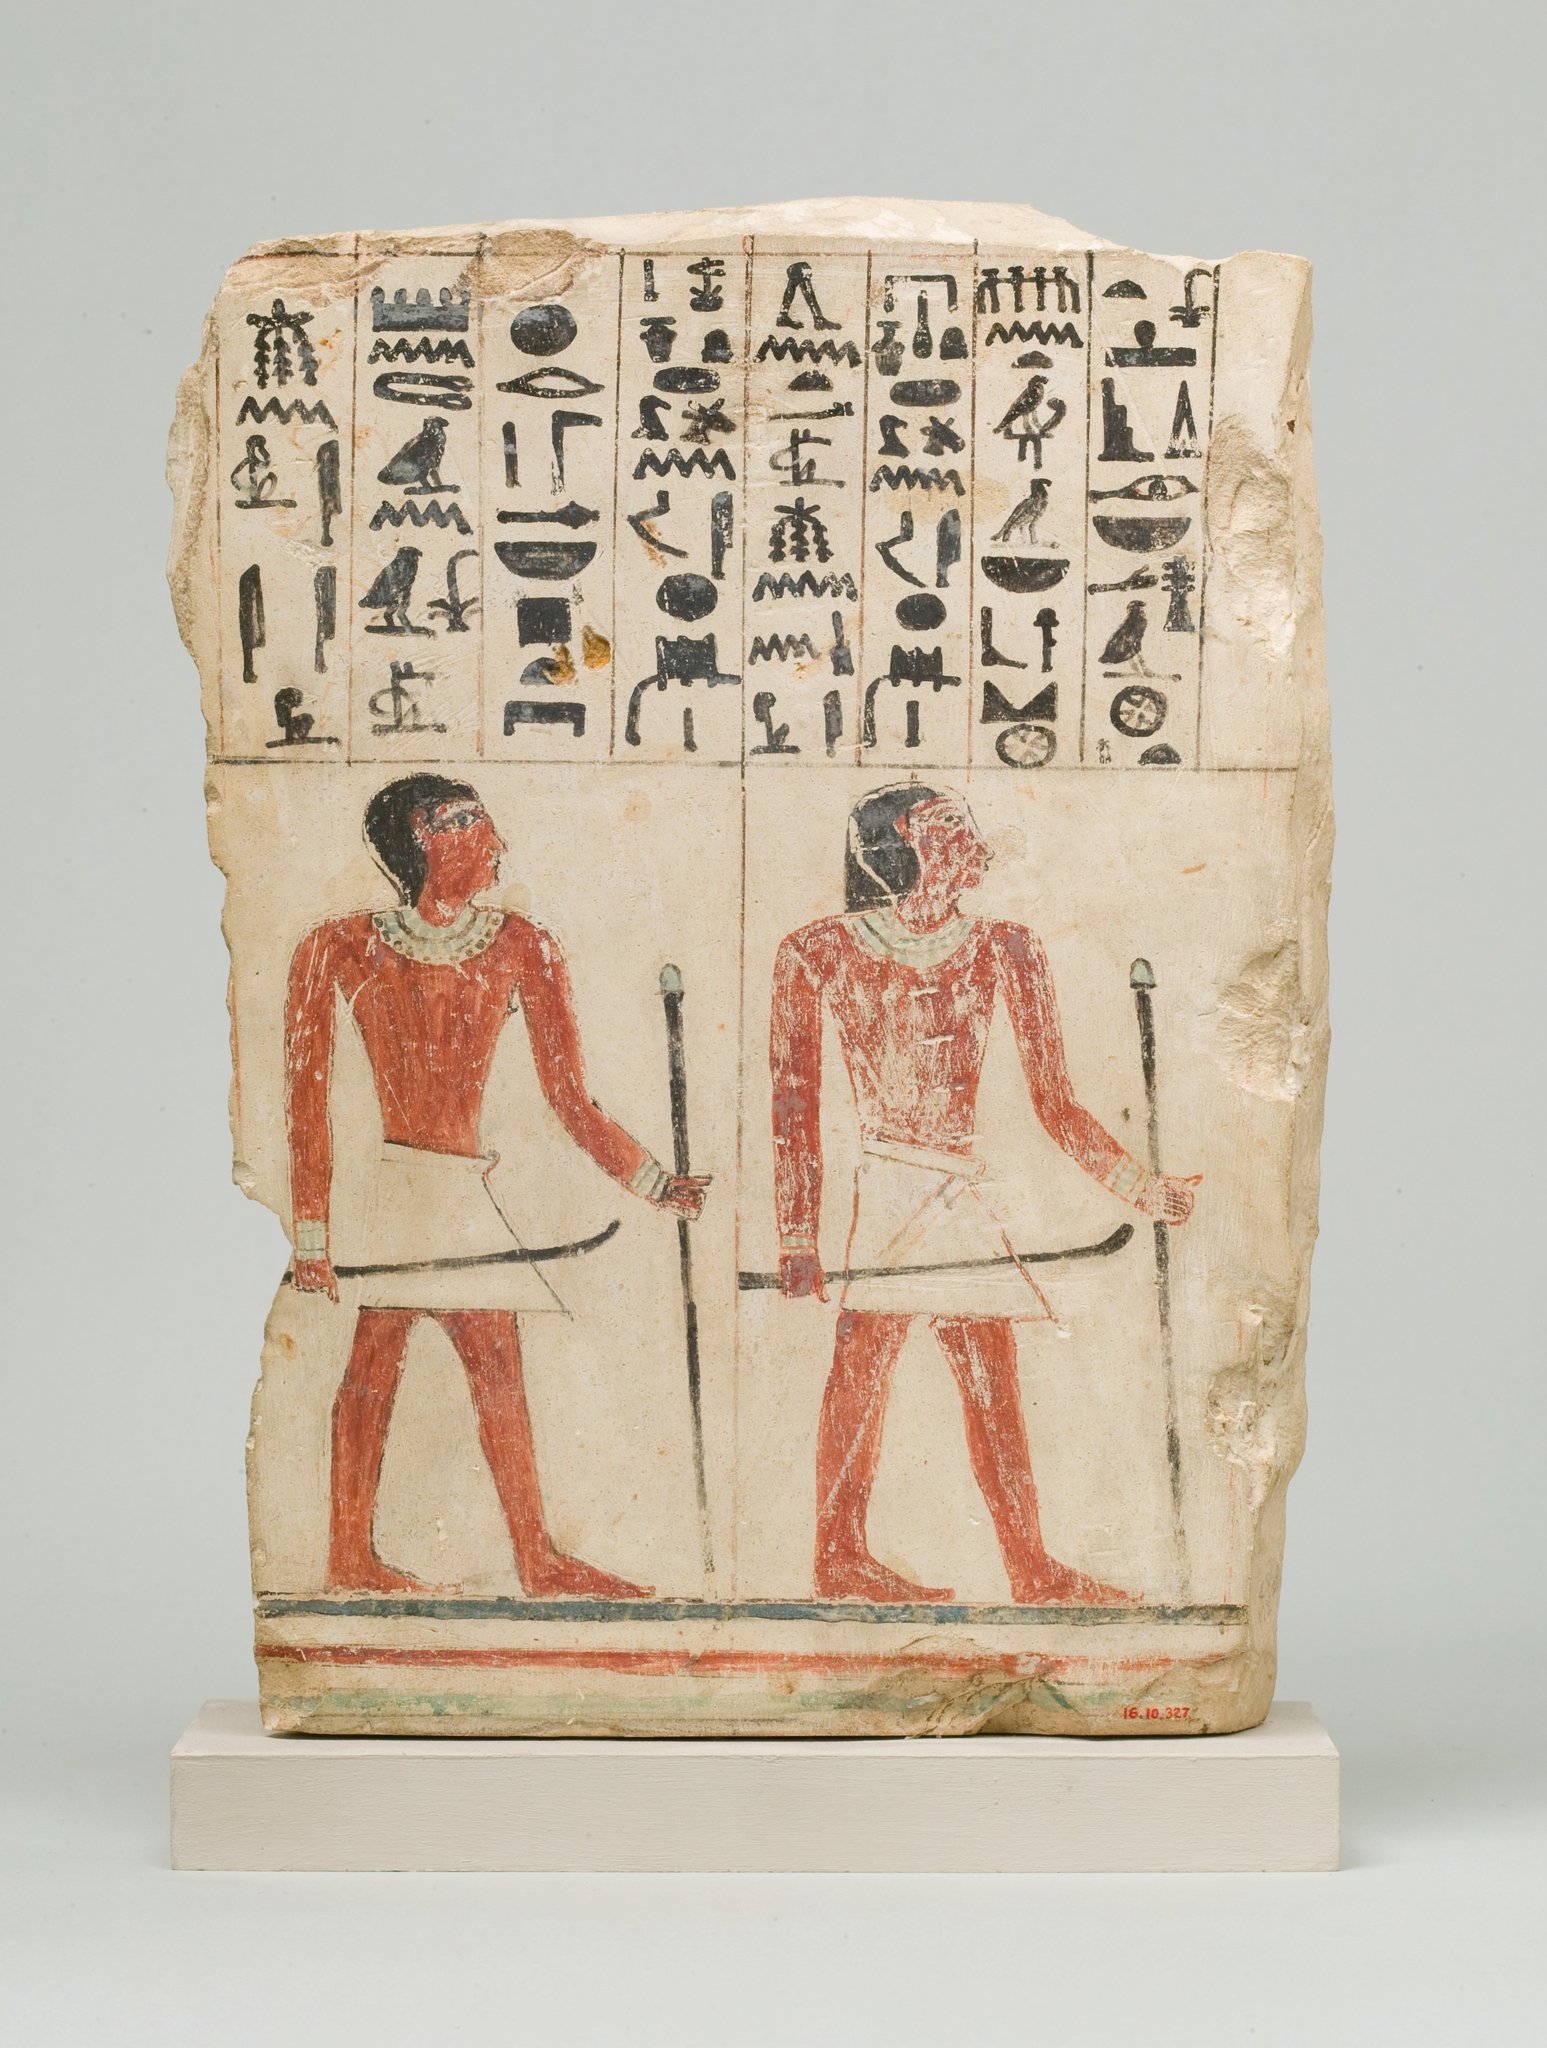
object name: stela, intef and nesumontu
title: Stela of Intef and Nesumontu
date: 1961-1917 BCE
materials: limestone, paint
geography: egypt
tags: men,hieroglyphs